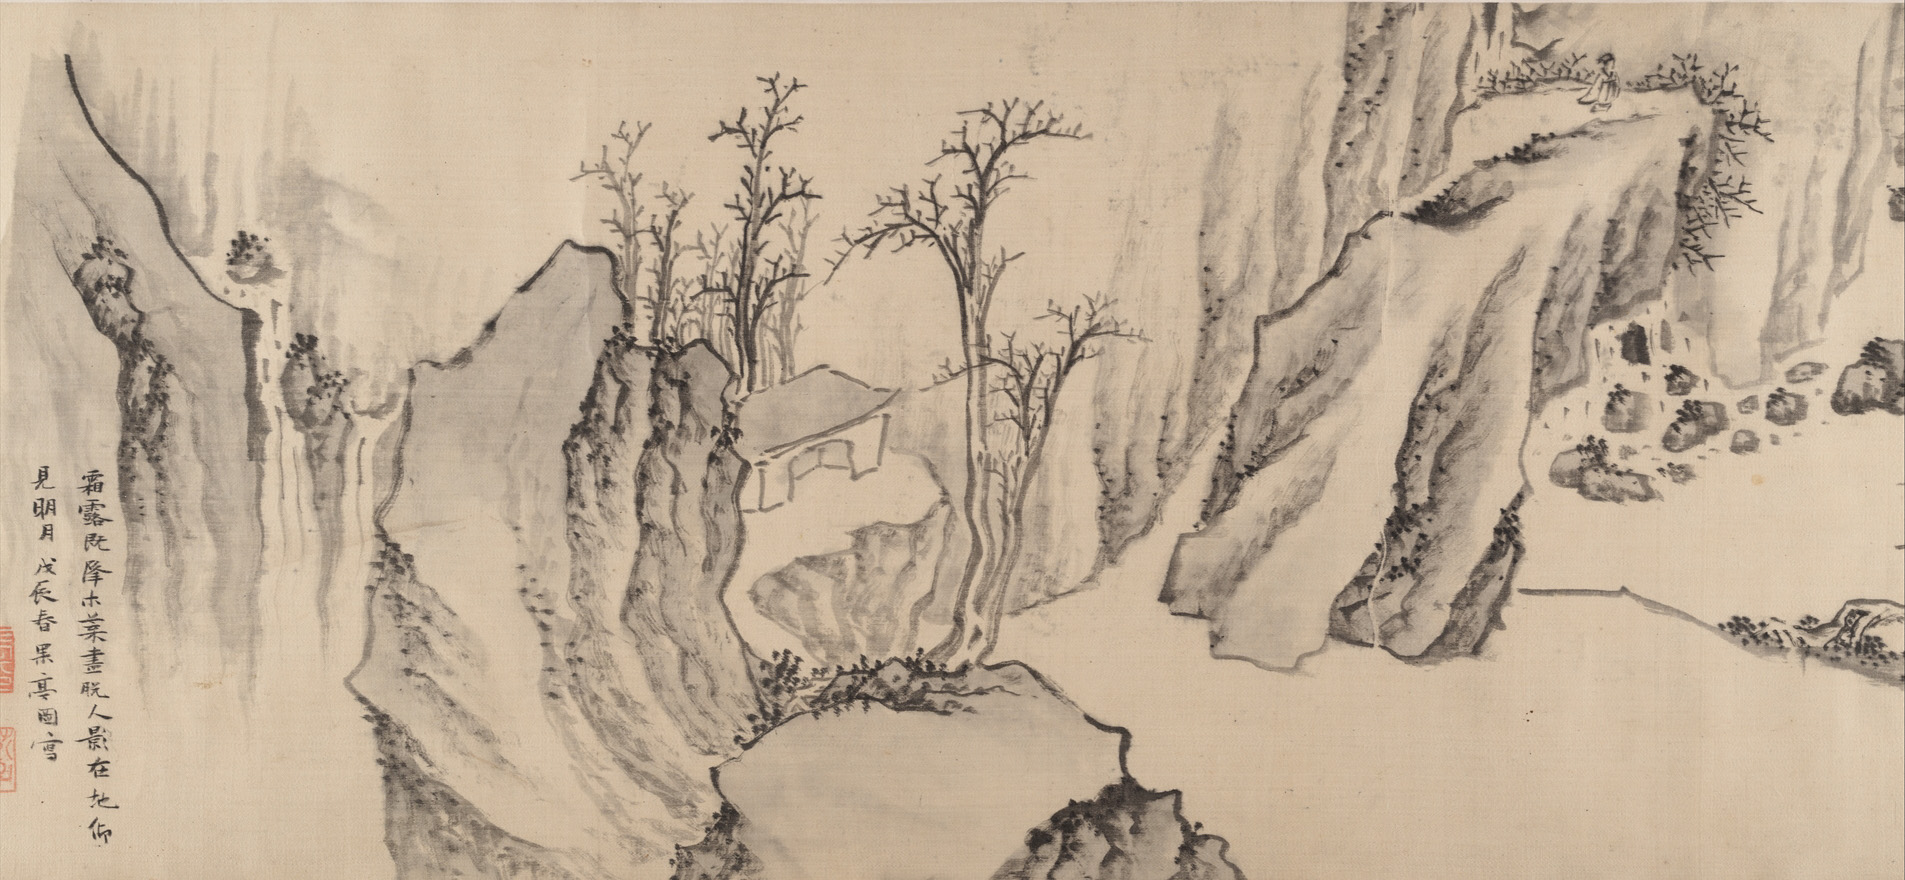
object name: handscroll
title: Illustration of Su Shi’s “Second Rhapsody on Red Cliff”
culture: chinese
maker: zhang ruitu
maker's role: artist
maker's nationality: chinese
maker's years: 1570-1641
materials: ink, textile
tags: mountains,landscapes